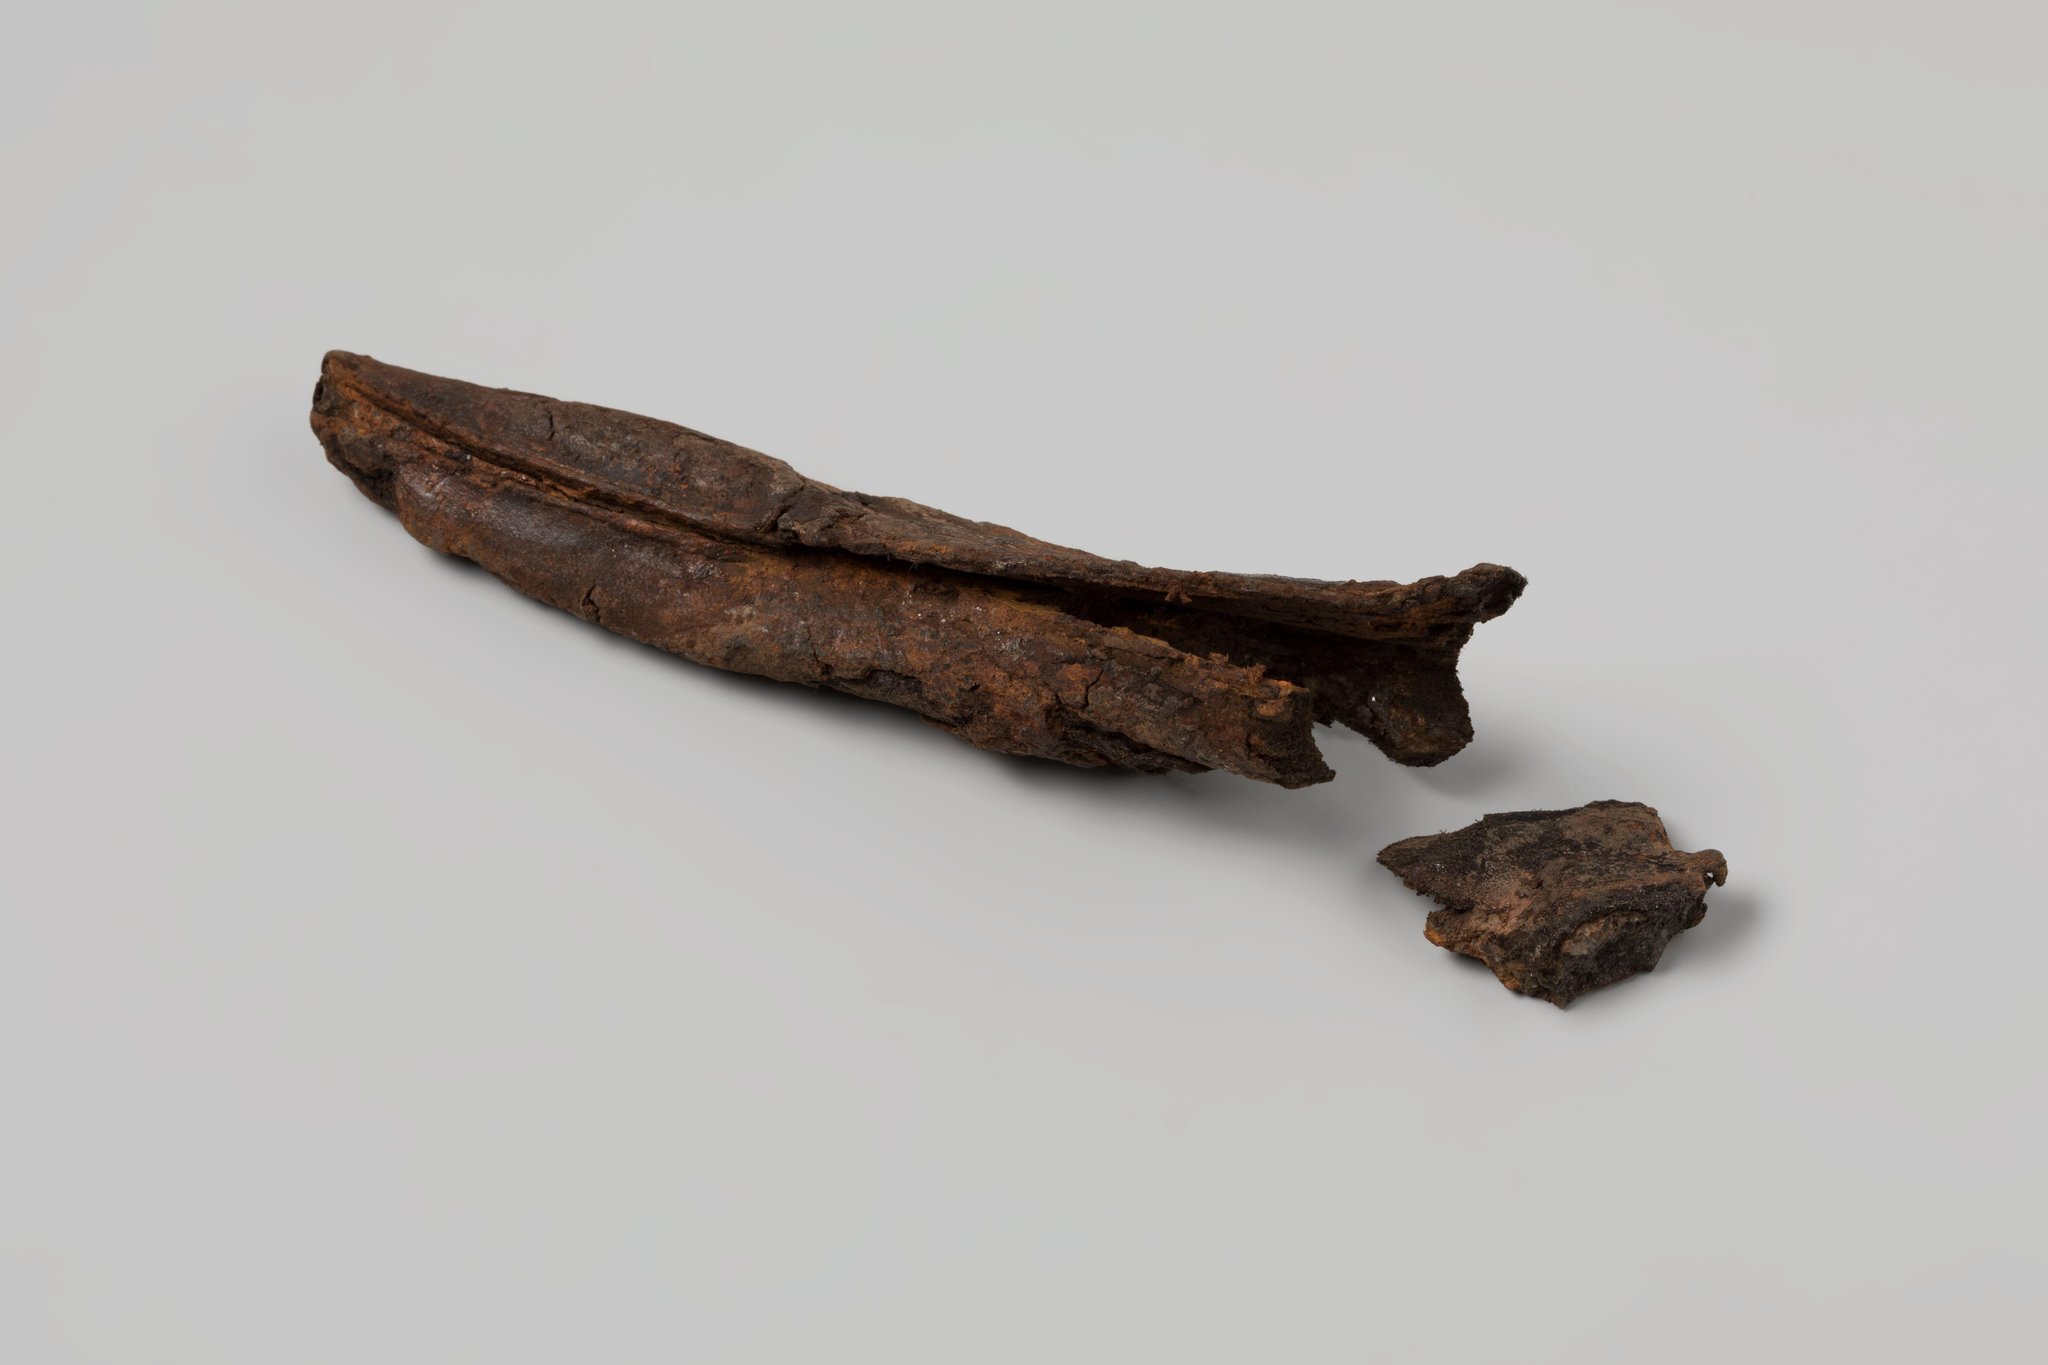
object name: knife tool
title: Schede van mes uit het wrak van de Oost-Indiëvaarder Hollandia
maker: Anonymous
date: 1700-1743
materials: leather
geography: netherlands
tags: verenigde oostindische compagnie, hollandia (schip), annet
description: Knife, scabbard; fragm, eroded: tapering, pointed lower end, longitudinal seam, oval in section.